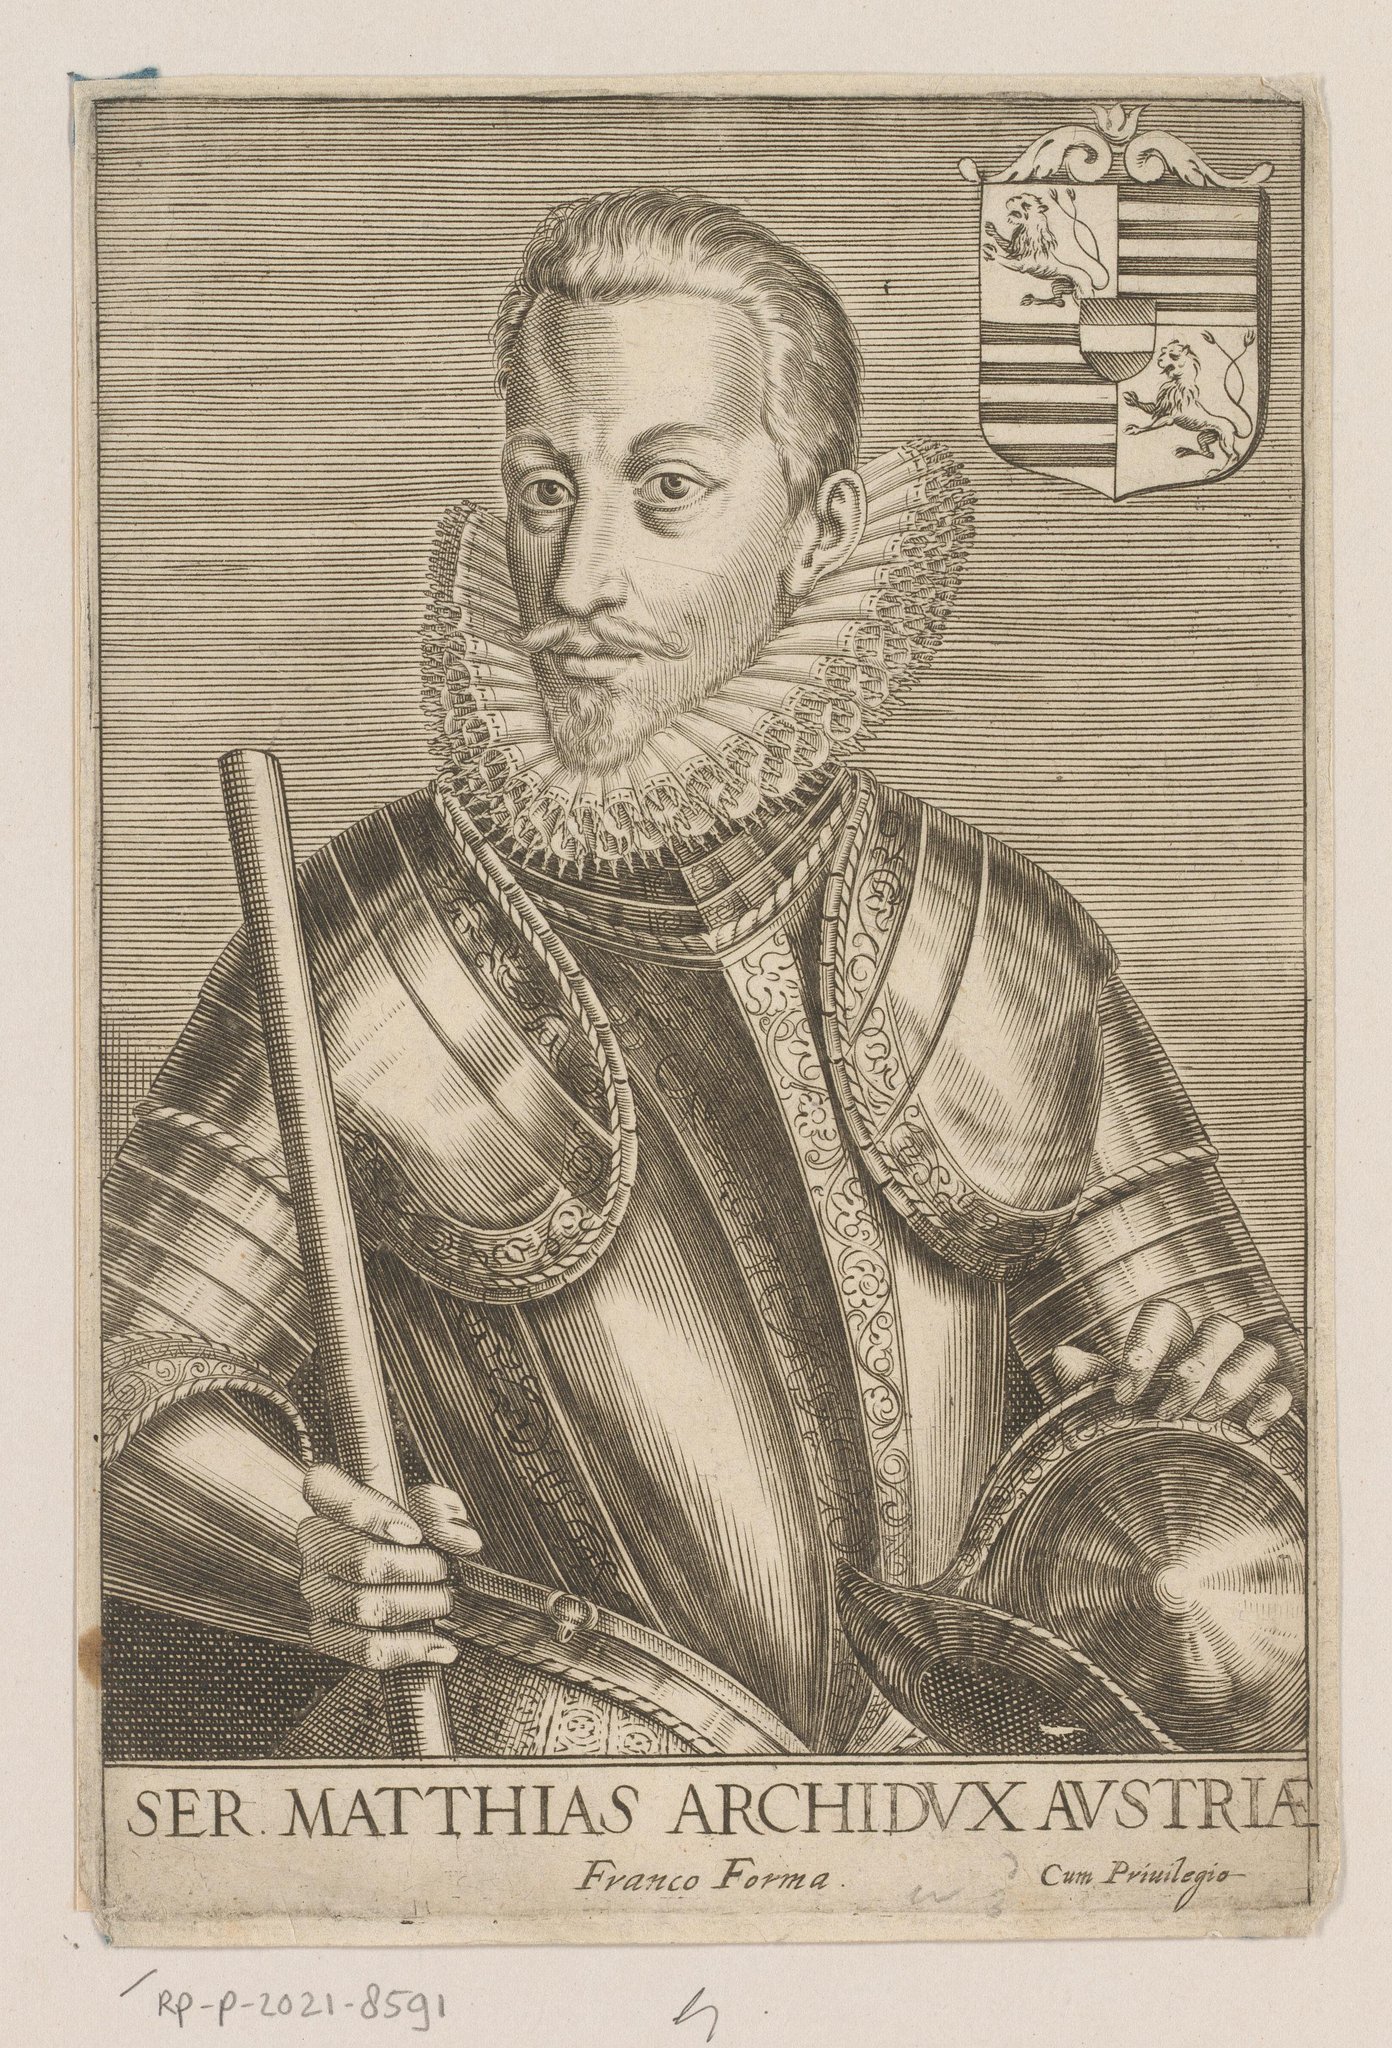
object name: print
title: Effigie naturali dei maggior prencipi et piu valorosi capitani di questa eta con l'arme loro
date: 1596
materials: paper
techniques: engraving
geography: venice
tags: vienna, matthias van oostenrijk (rooms-duits keizer), armour, historical persons, armorial bearing, heraldry